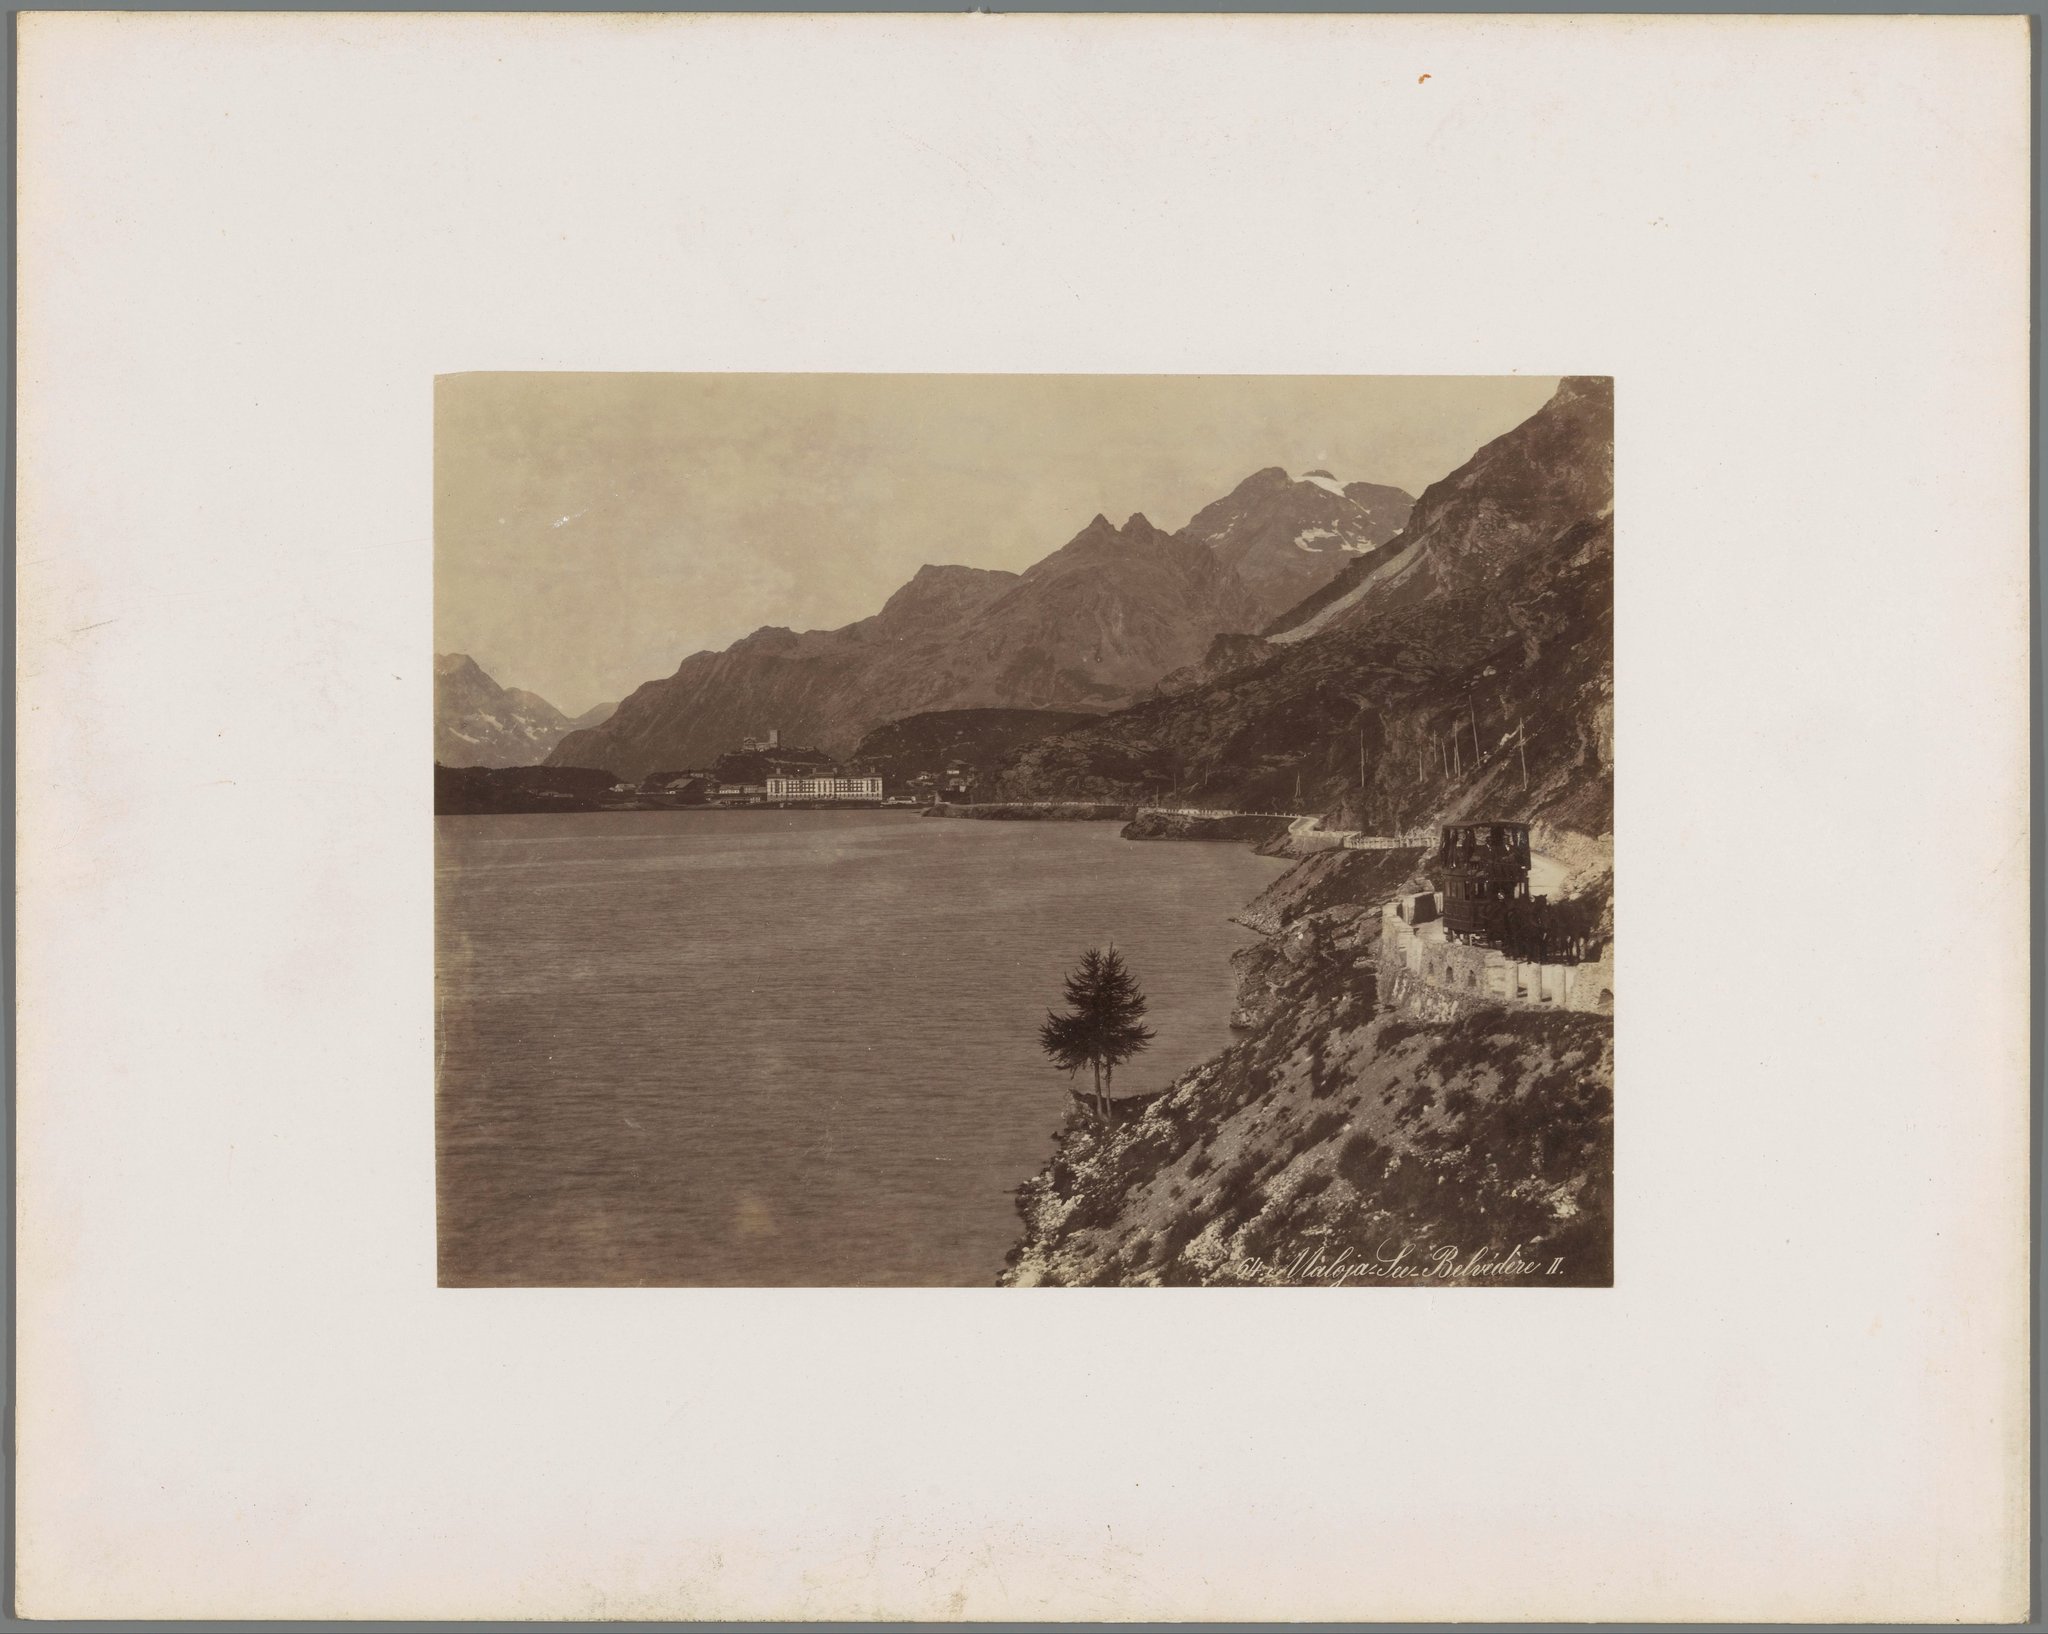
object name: photograph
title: Maloja-See-Belvédère II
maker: Anonymous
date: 1884-1890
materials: cardboard, paper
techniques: albumen print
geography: maloja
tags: lake, hotel, hostelry, inn, maloja palace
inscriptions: number: ‘64.’